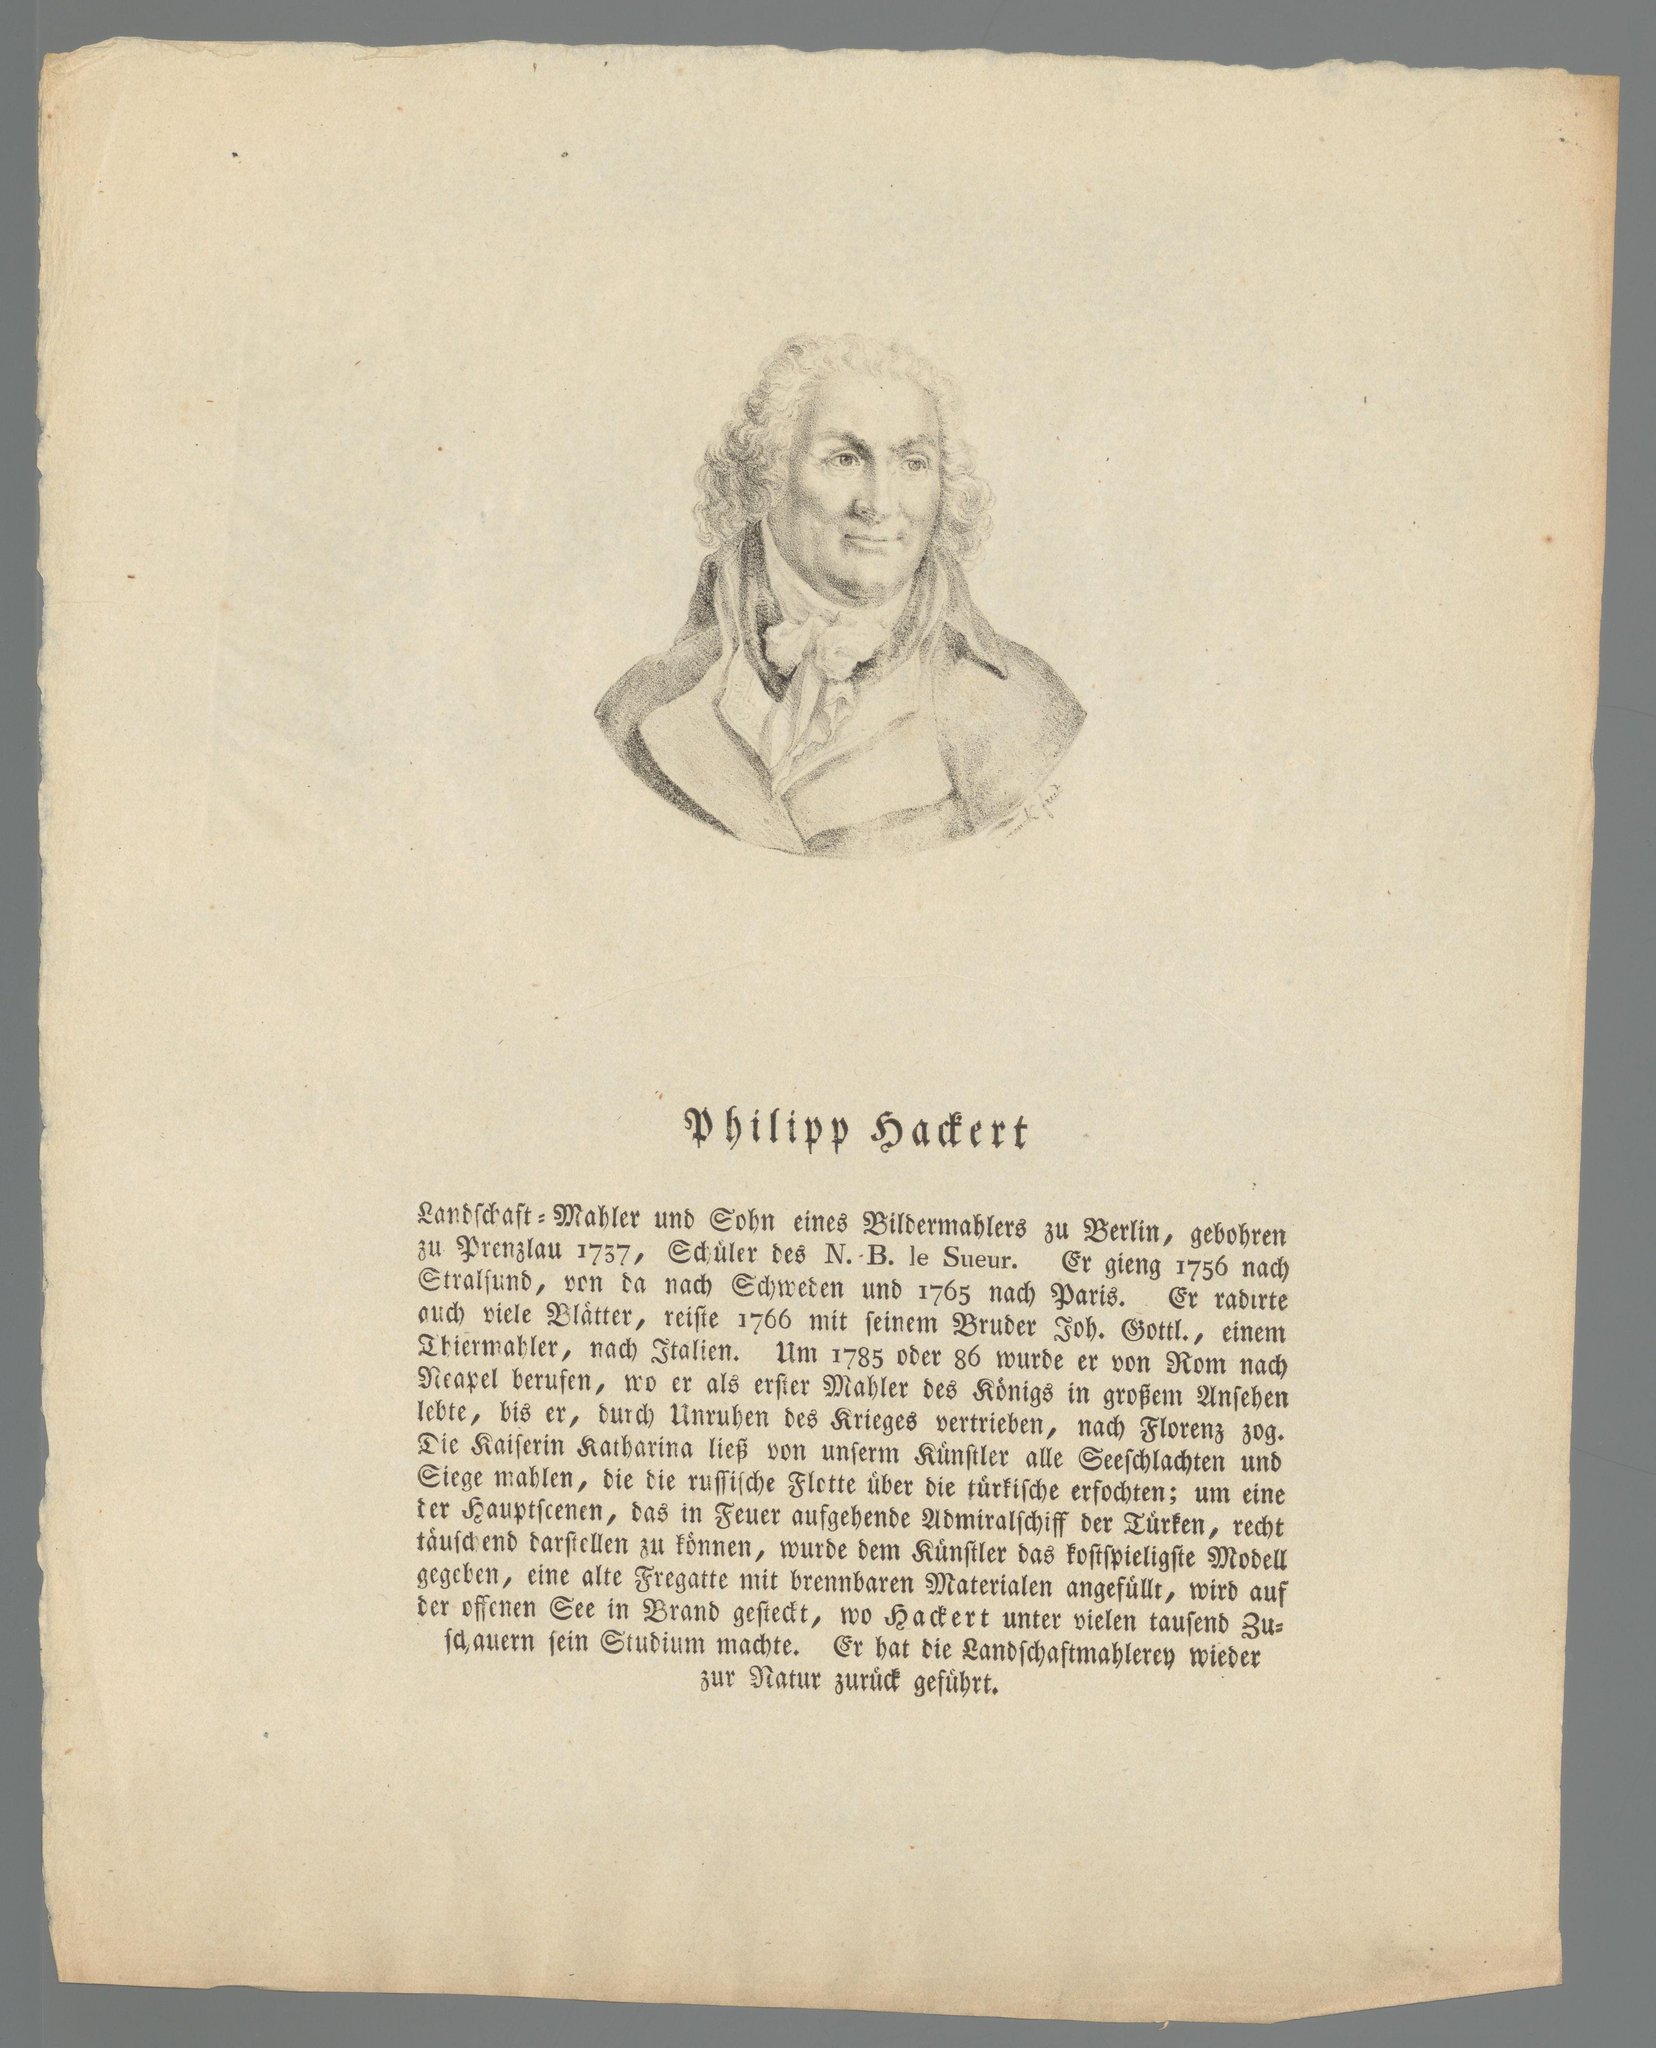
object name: book illustration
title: Portret van Philipp Hackert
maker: maximilian franck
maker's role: print maker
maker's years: 1780-1830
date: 1813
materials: paper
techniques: letterpress printing, lithograph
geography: munich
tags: painter, historical persons, portrait, self-portrait of painter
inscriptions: collector's mark: Lugt 2228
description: Prent uit: Lindauer, Joseph. Deutsche Künstler-Gallerie. München: Maximilian Franck, 1813.